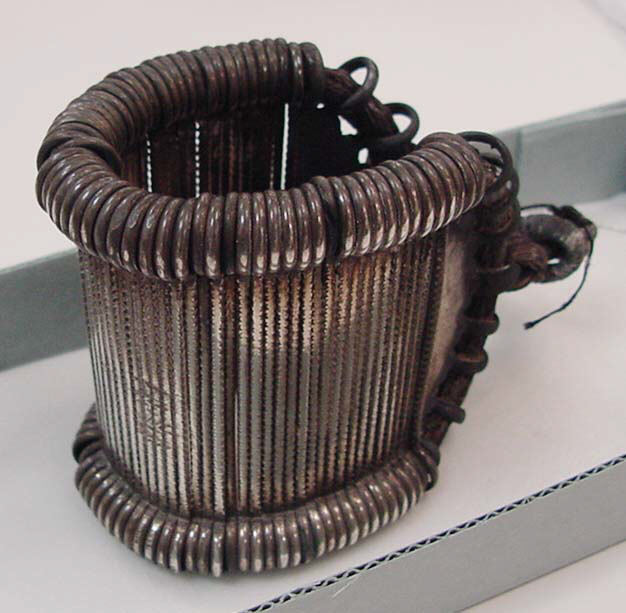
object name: bracelet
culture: indian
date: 1801-1900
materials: cotton, metal